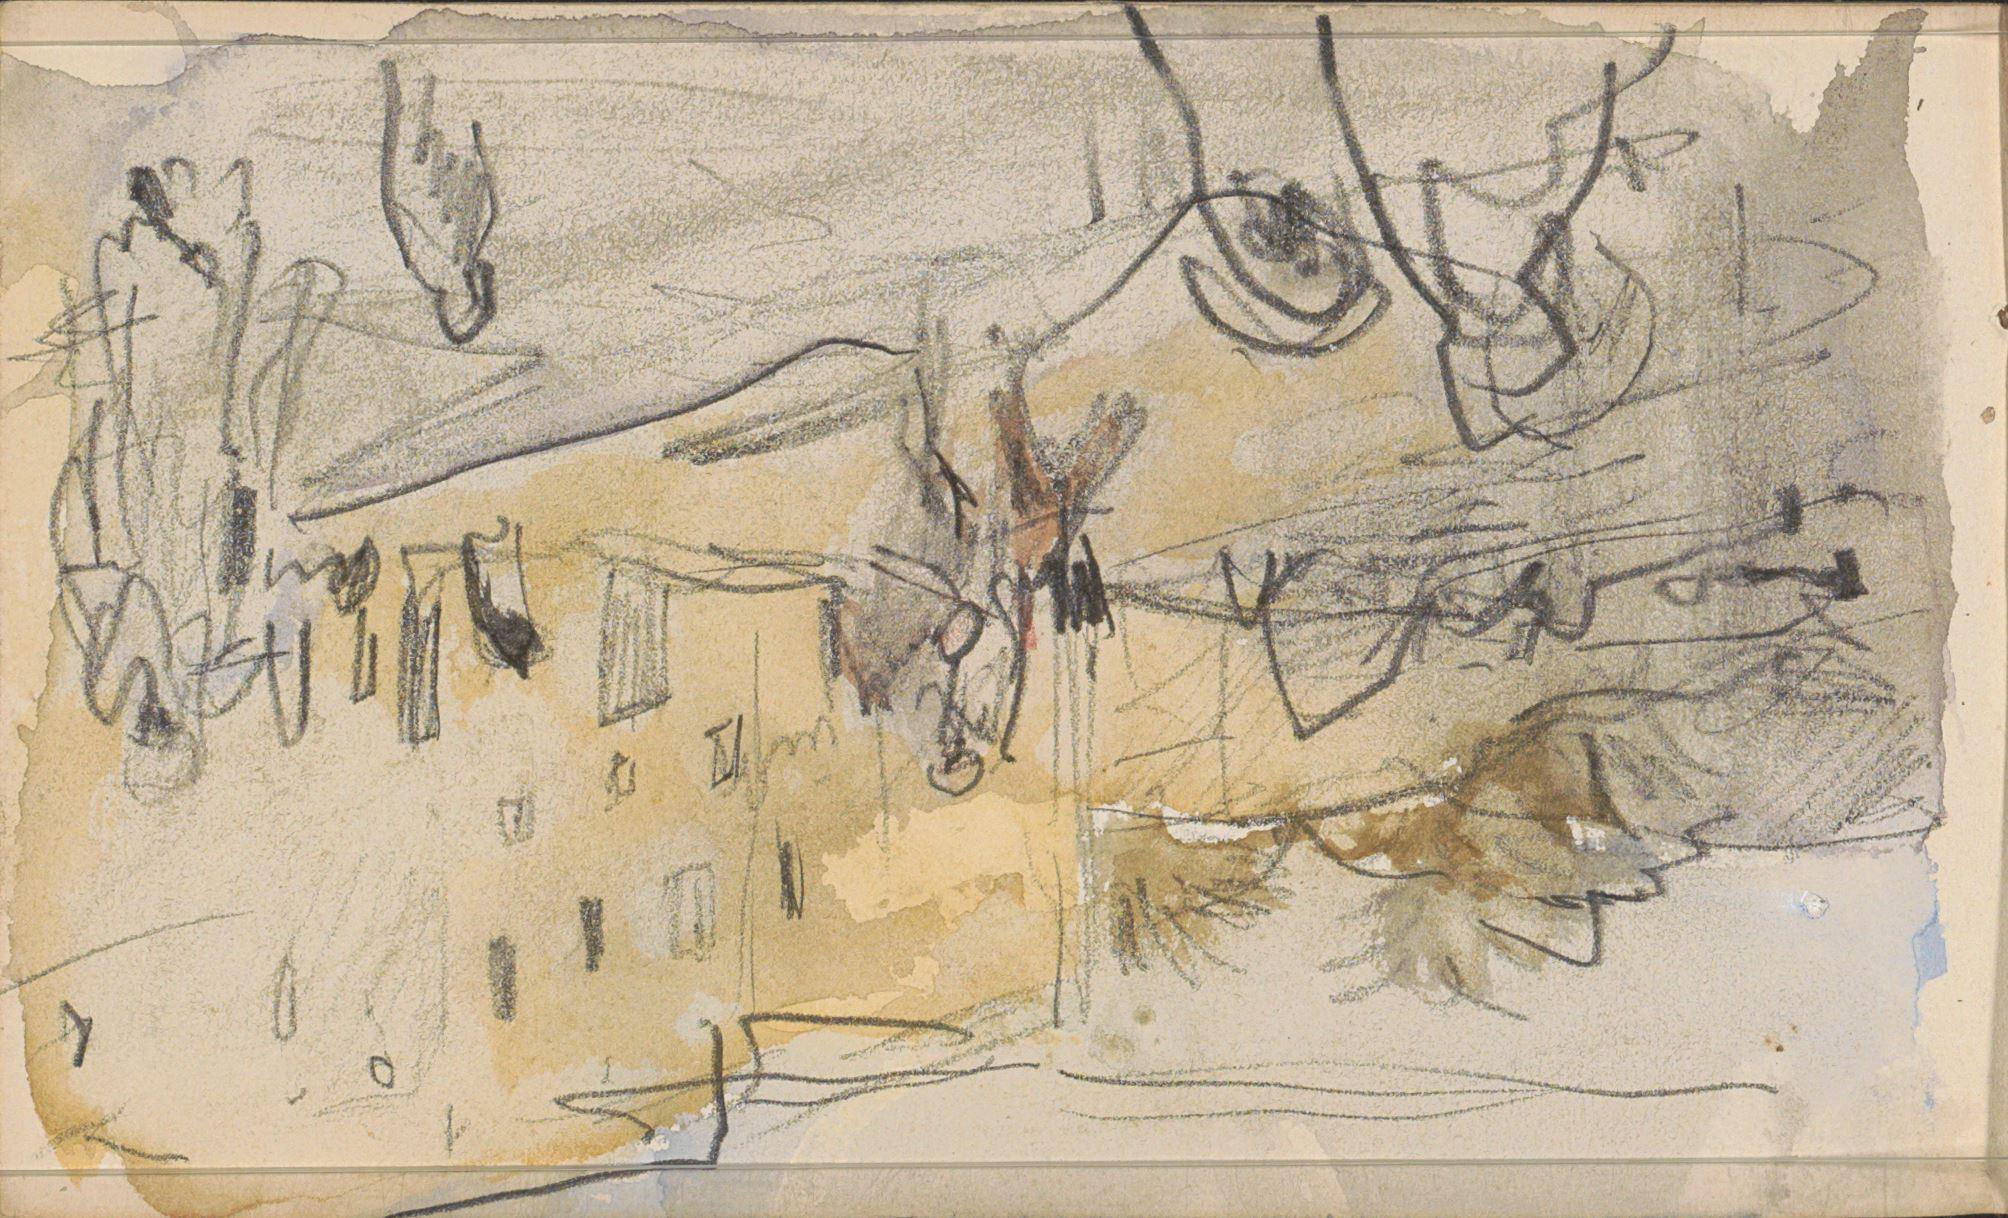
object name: sketchbook leaf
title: Straat met figuren in Biskra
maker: marius bauer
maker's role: draughtsman, print maker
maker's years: 1867-1932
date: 1922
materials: paper, pencil, watercolor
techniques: brush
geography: biskra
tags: africans, street (+ city(-scape) with figures, staffage)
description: Pagina 10 uit een schetsboek met 31 bladen.